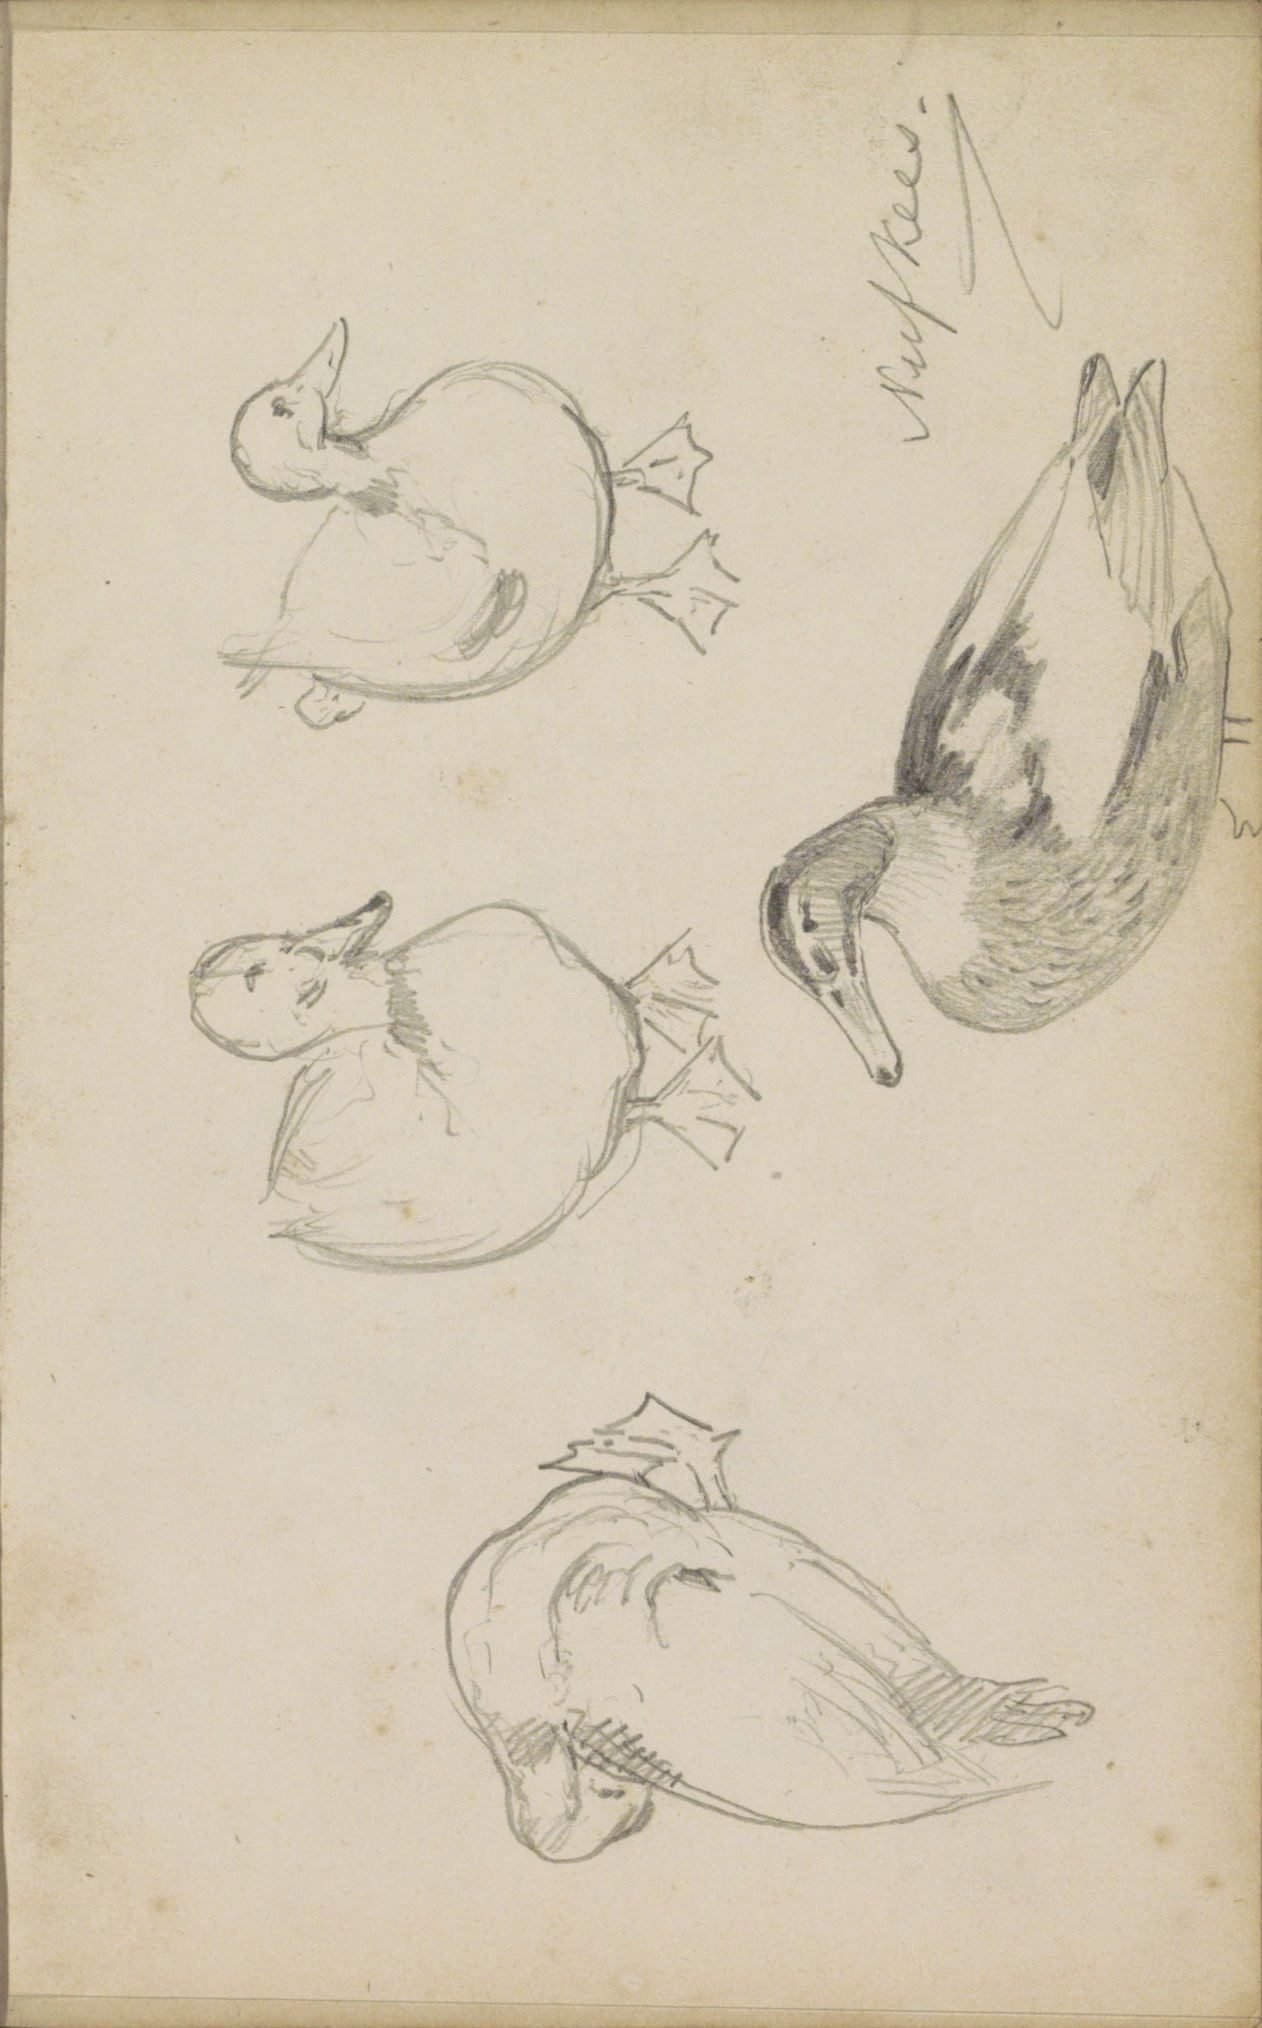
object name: sketchbook leaf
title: Eenden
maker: johannes tavenraat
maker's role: draughtsman, painter, print maker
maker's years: 1809-1881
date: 1839-1872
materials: paper, pencil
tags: water-birds: duck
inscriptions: annotation: ‘NeefKees.’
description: Blad 26 recto uit een schetsboek met 73 bladen.